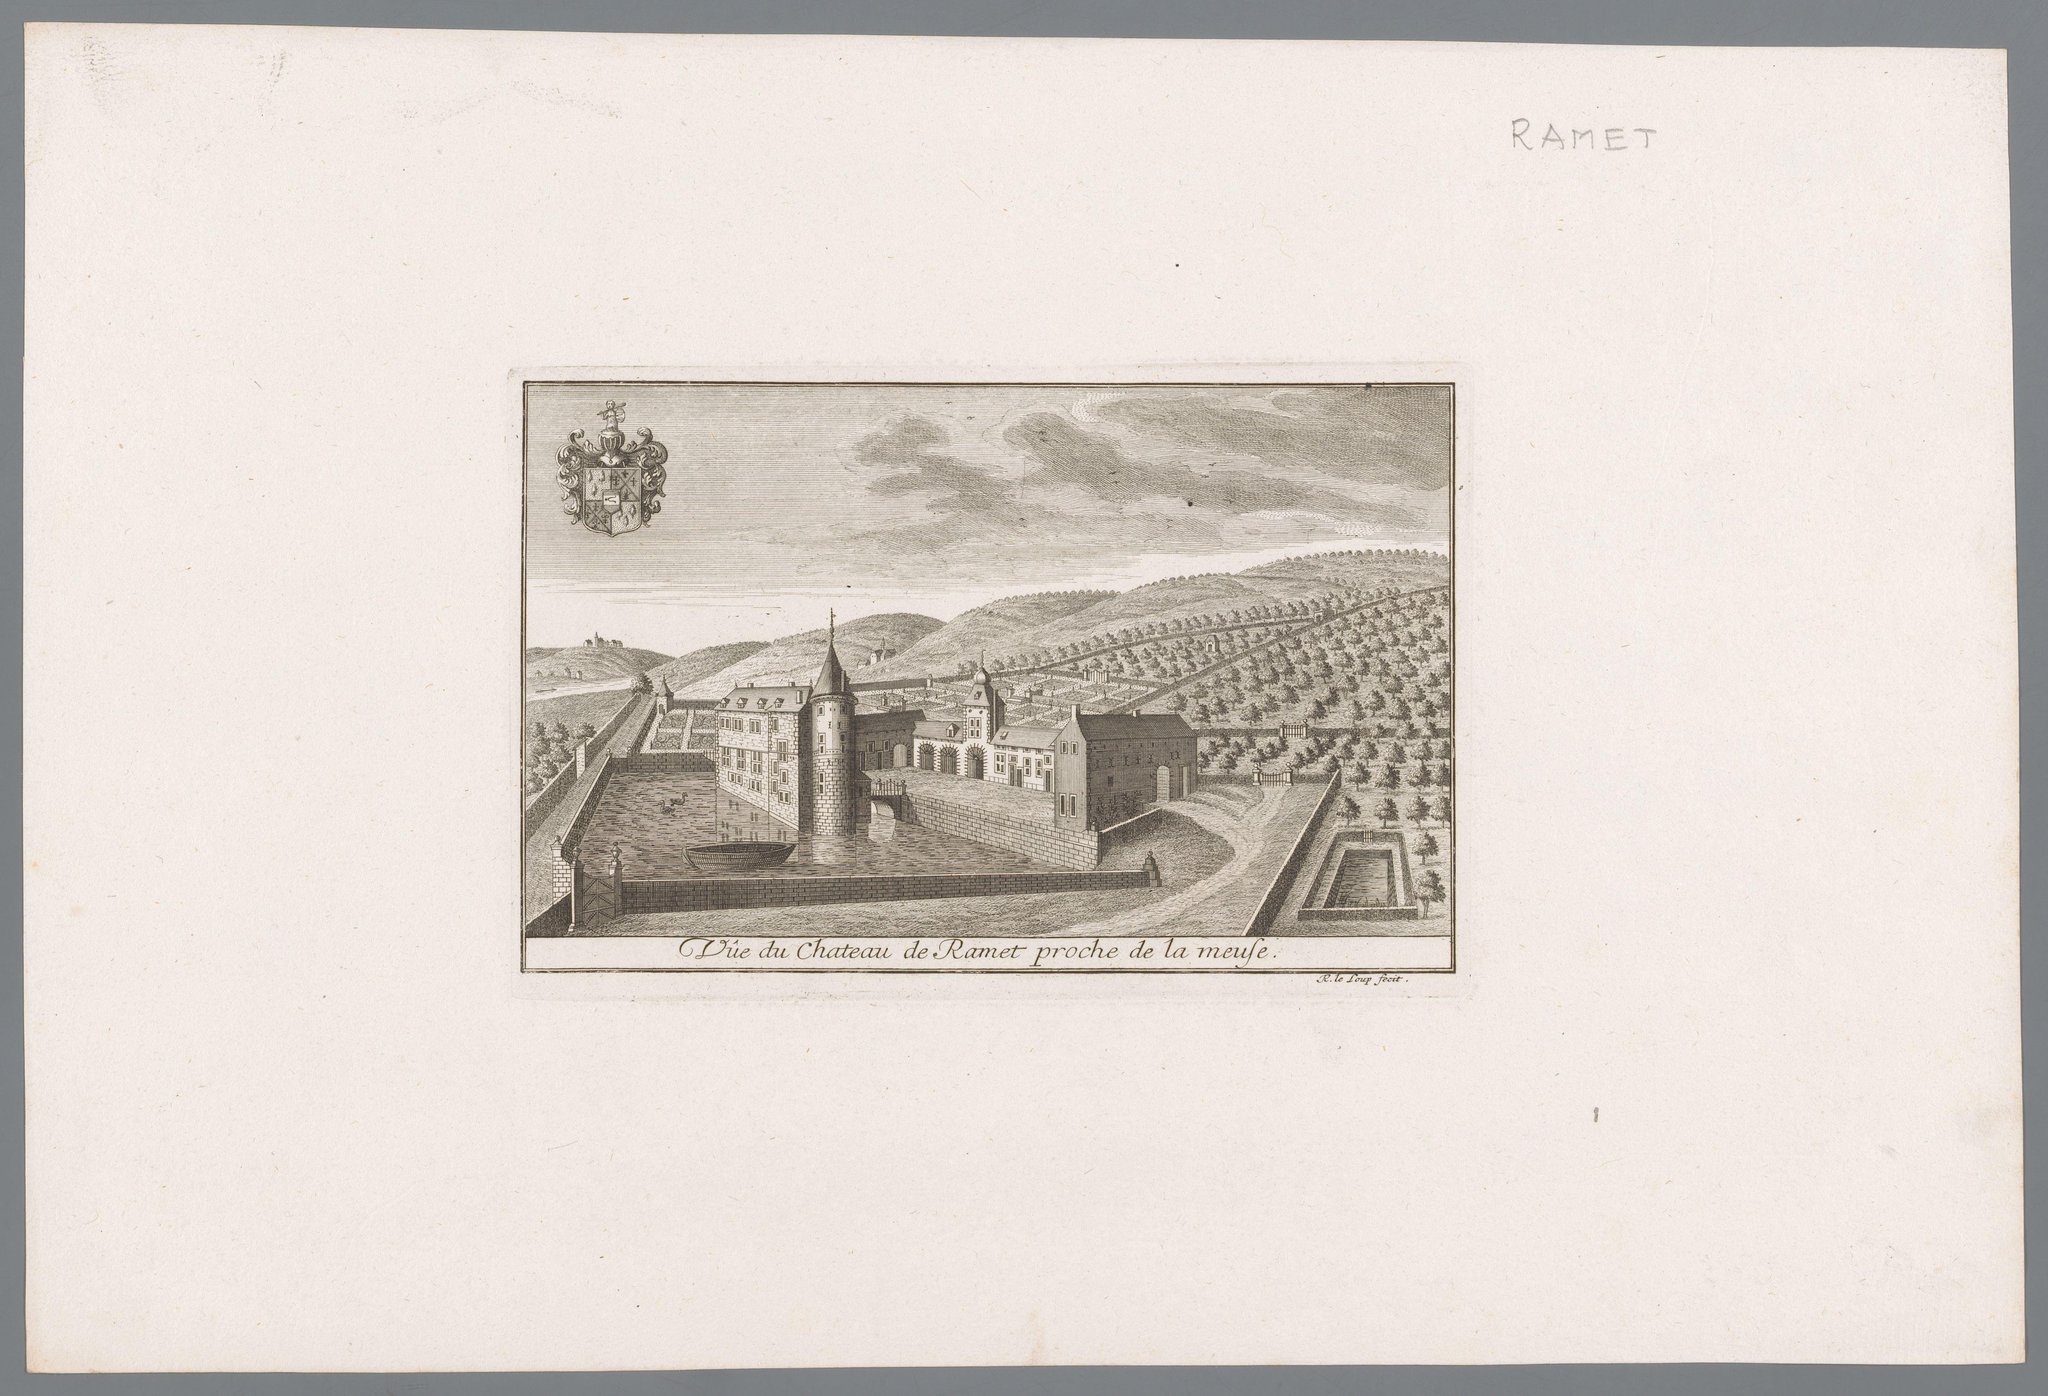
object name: print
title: Gezicht op het kasteel bij Ivoz-Ramet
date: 1738-1744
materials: paper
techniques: engraving, etching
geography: liège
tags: castle, landscape with tower or castle, liège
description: Prent uit: Johanne de Saumery, Alexandre de et al. Les délices du païs de Liège, ou description géographique, topographique et chorographique des monumes sacrés et profanes (...). 5 dln. Luik: Everard Kints, 1738-1744, dl. 1, p. 350.